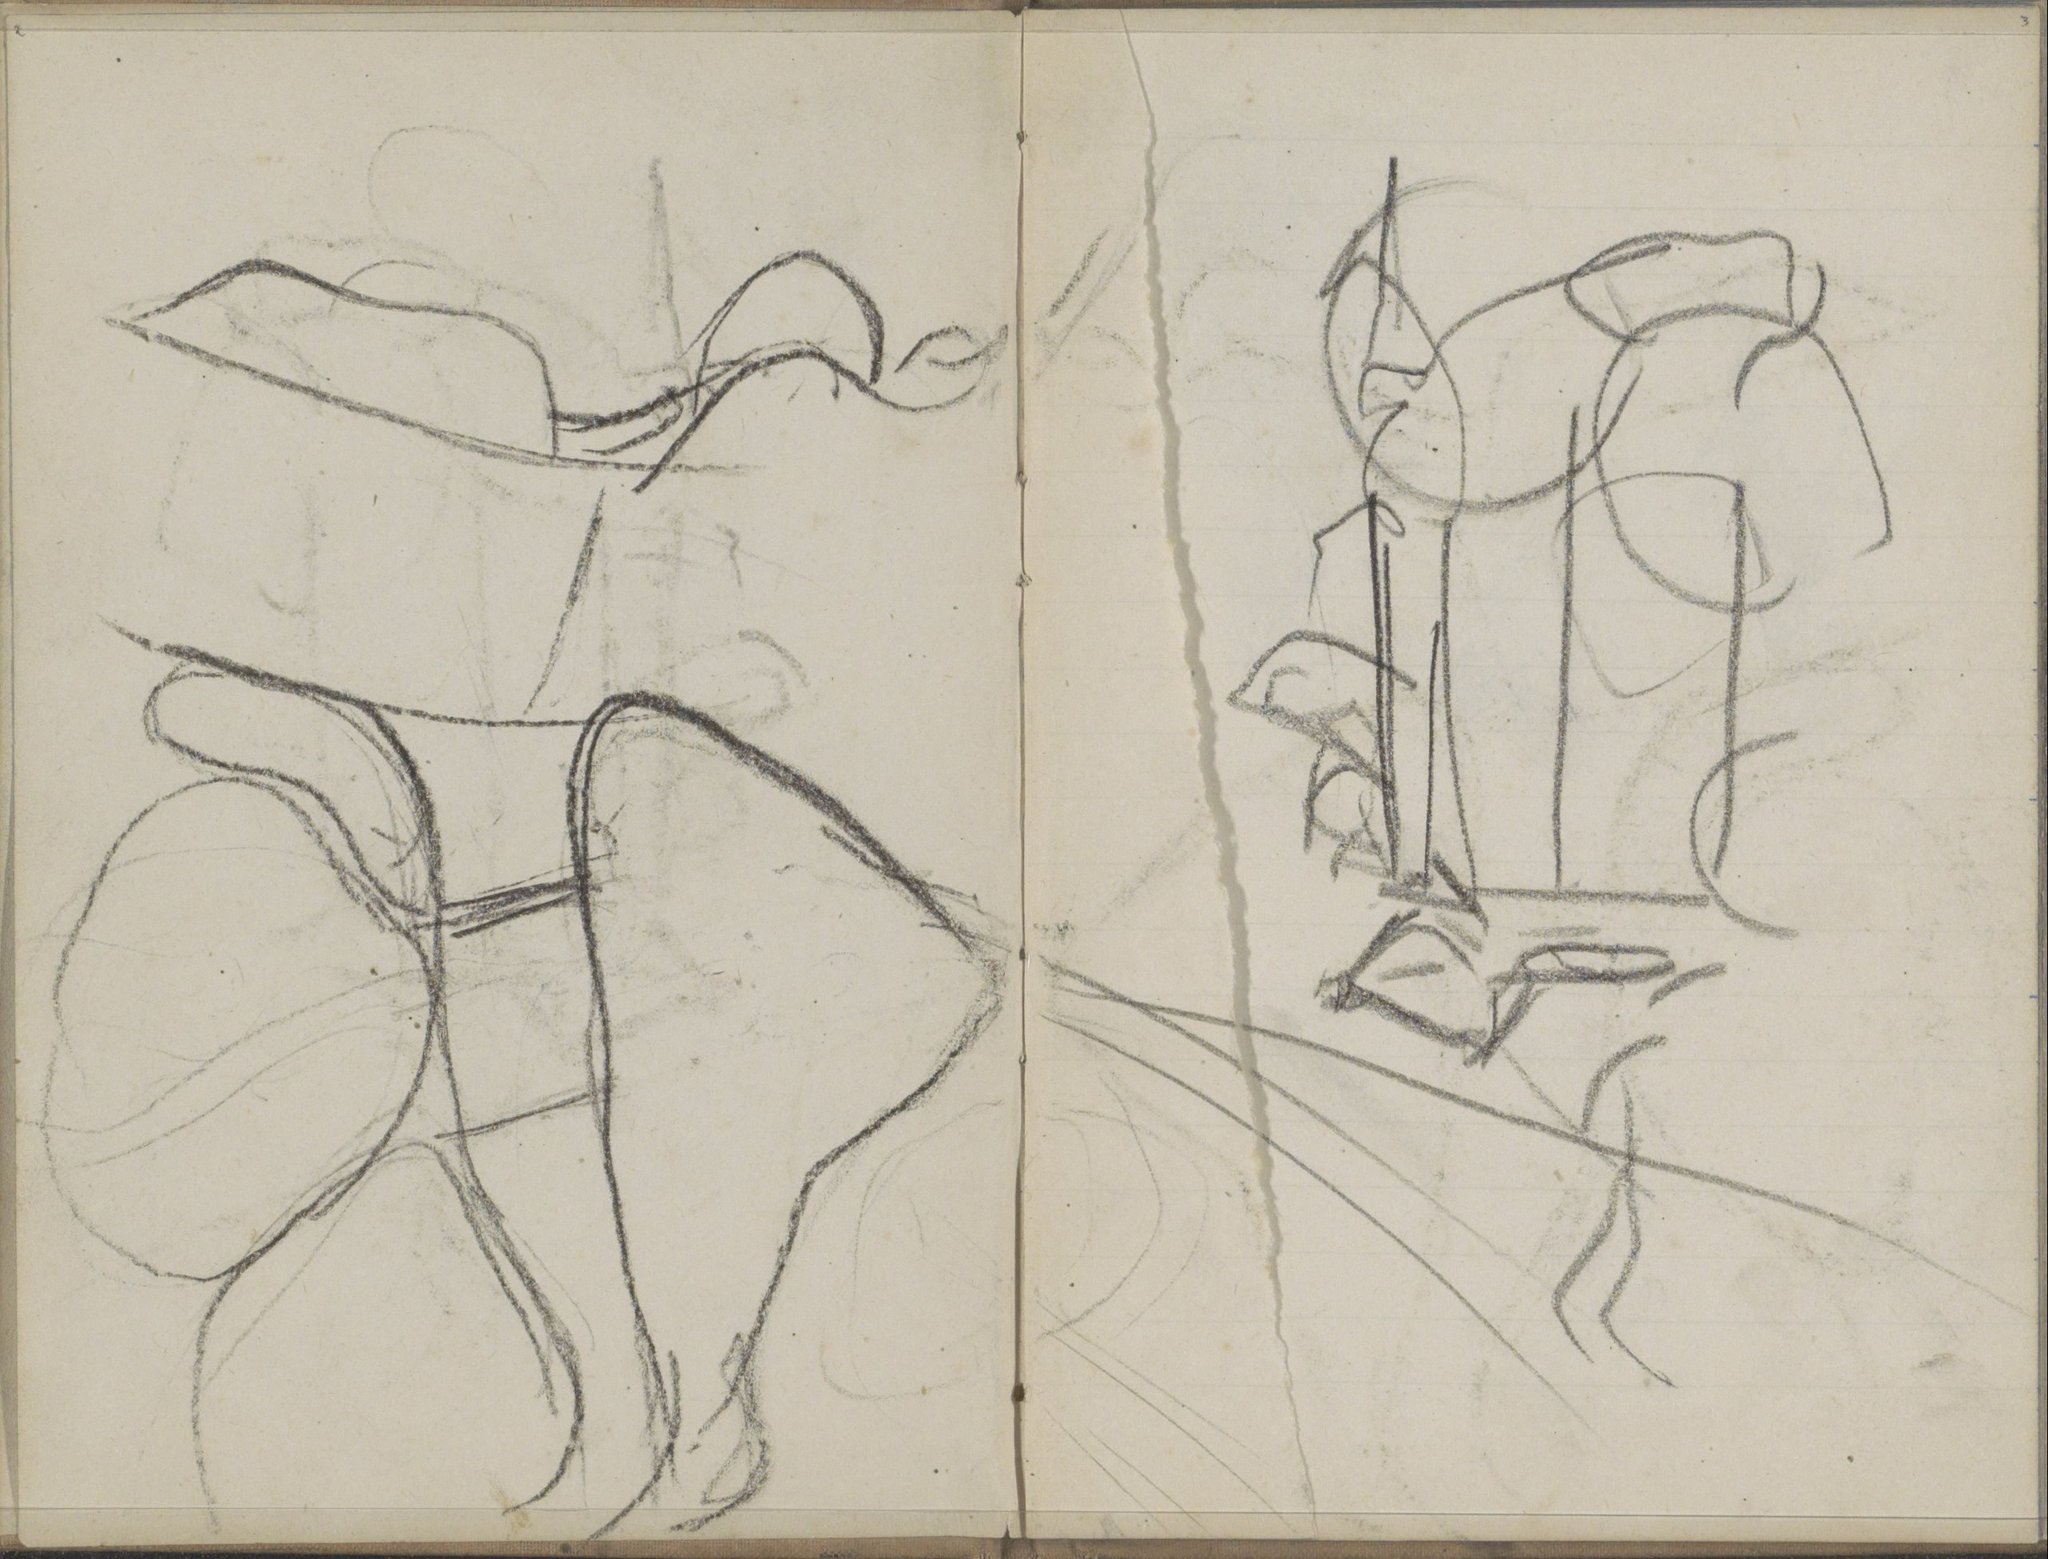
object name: sketchbook leaf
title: Studieblad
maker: marius bauer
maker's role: draughtsman, print maker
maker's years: 1867-1932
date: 1888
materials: chalk, paper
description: Pagina 2 uit een schetsboek met 49 bladen.